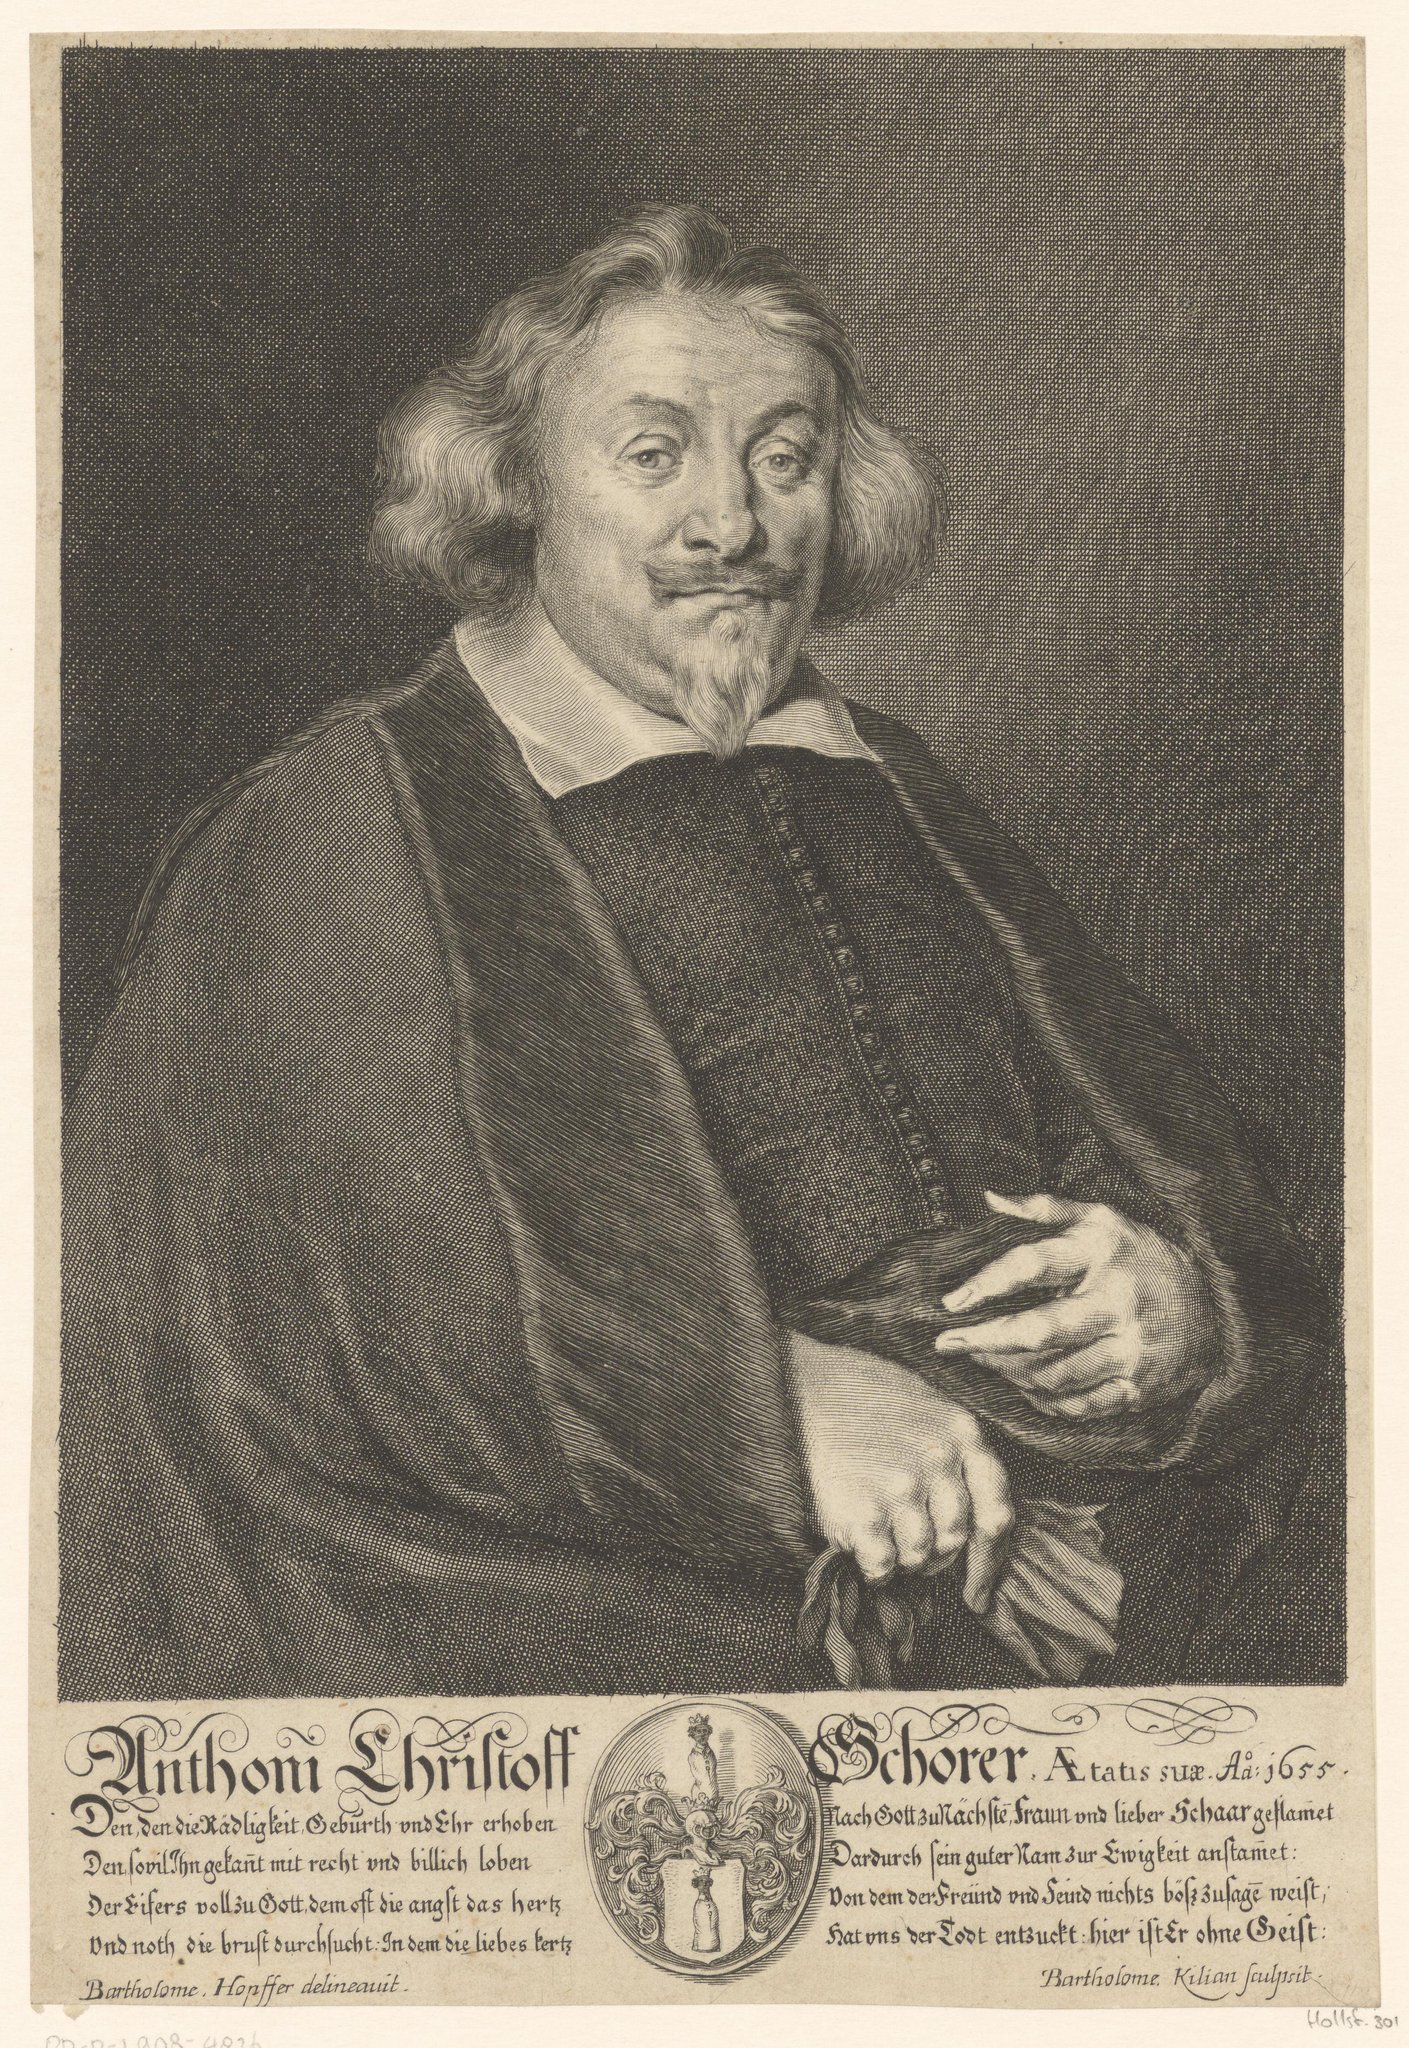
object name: print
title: Portret van Anton Christoph Schorer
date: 1655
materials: paper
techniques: engraving, etching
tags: historical persons, physician, doctor (+ portrait of scholar, scientist)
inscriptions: collector's mark: Lugt 2228